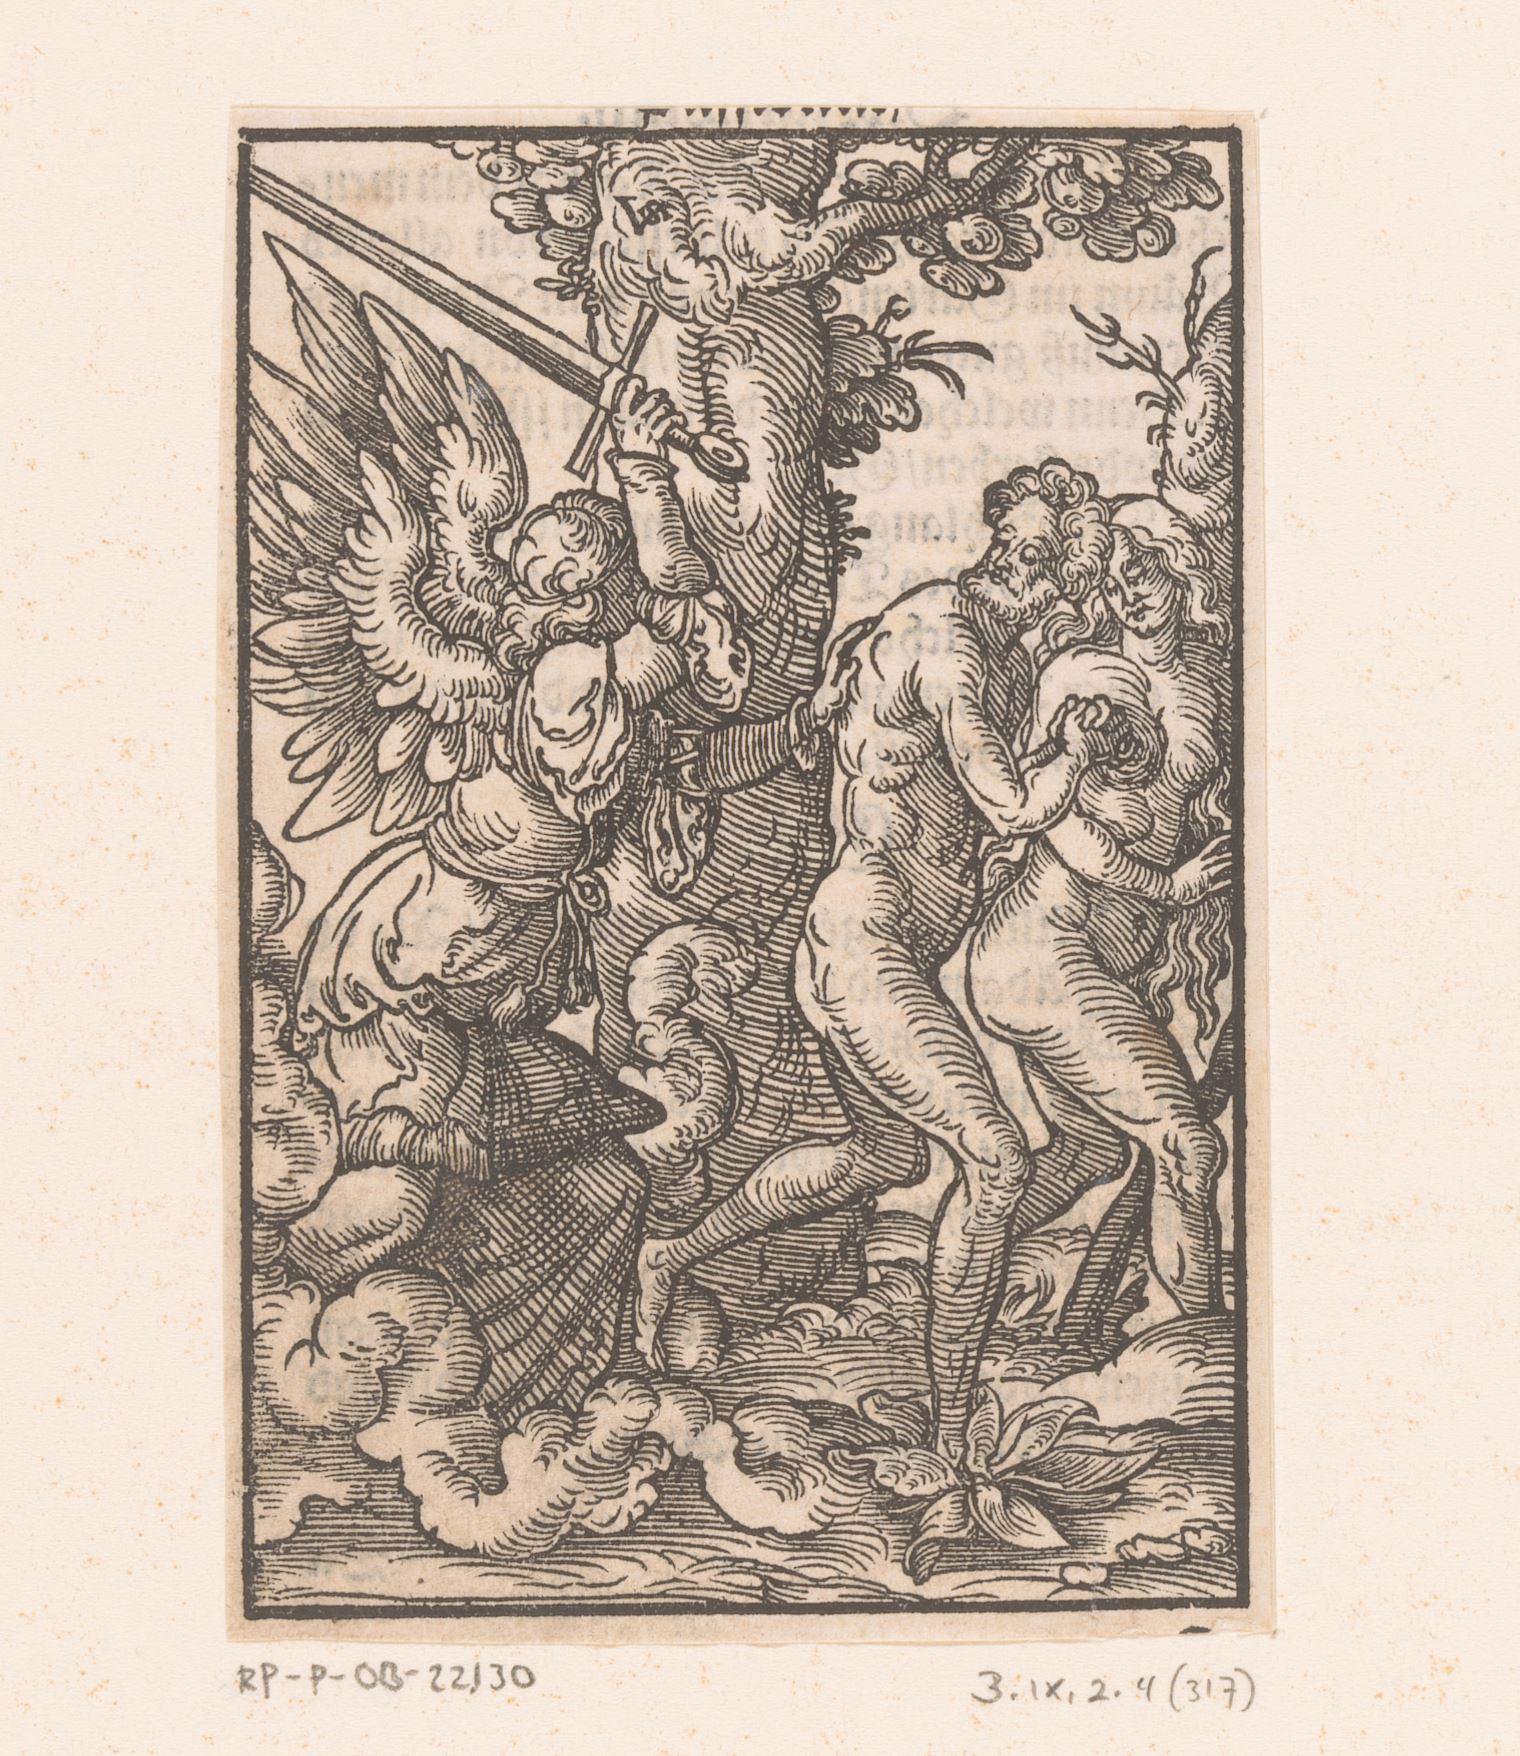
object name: print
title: Expulsion from Paradise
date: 1552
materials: paper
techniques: woodcut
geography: nuremberg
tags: an angel chases adam and eve out of paradise with a (flaming) sword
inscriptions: number: ‘181’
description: Gebruikt voor verschillende publicaties die werden gedrukt door Valentin Geißler tussen 1552 en 1560 te Neurenberg.